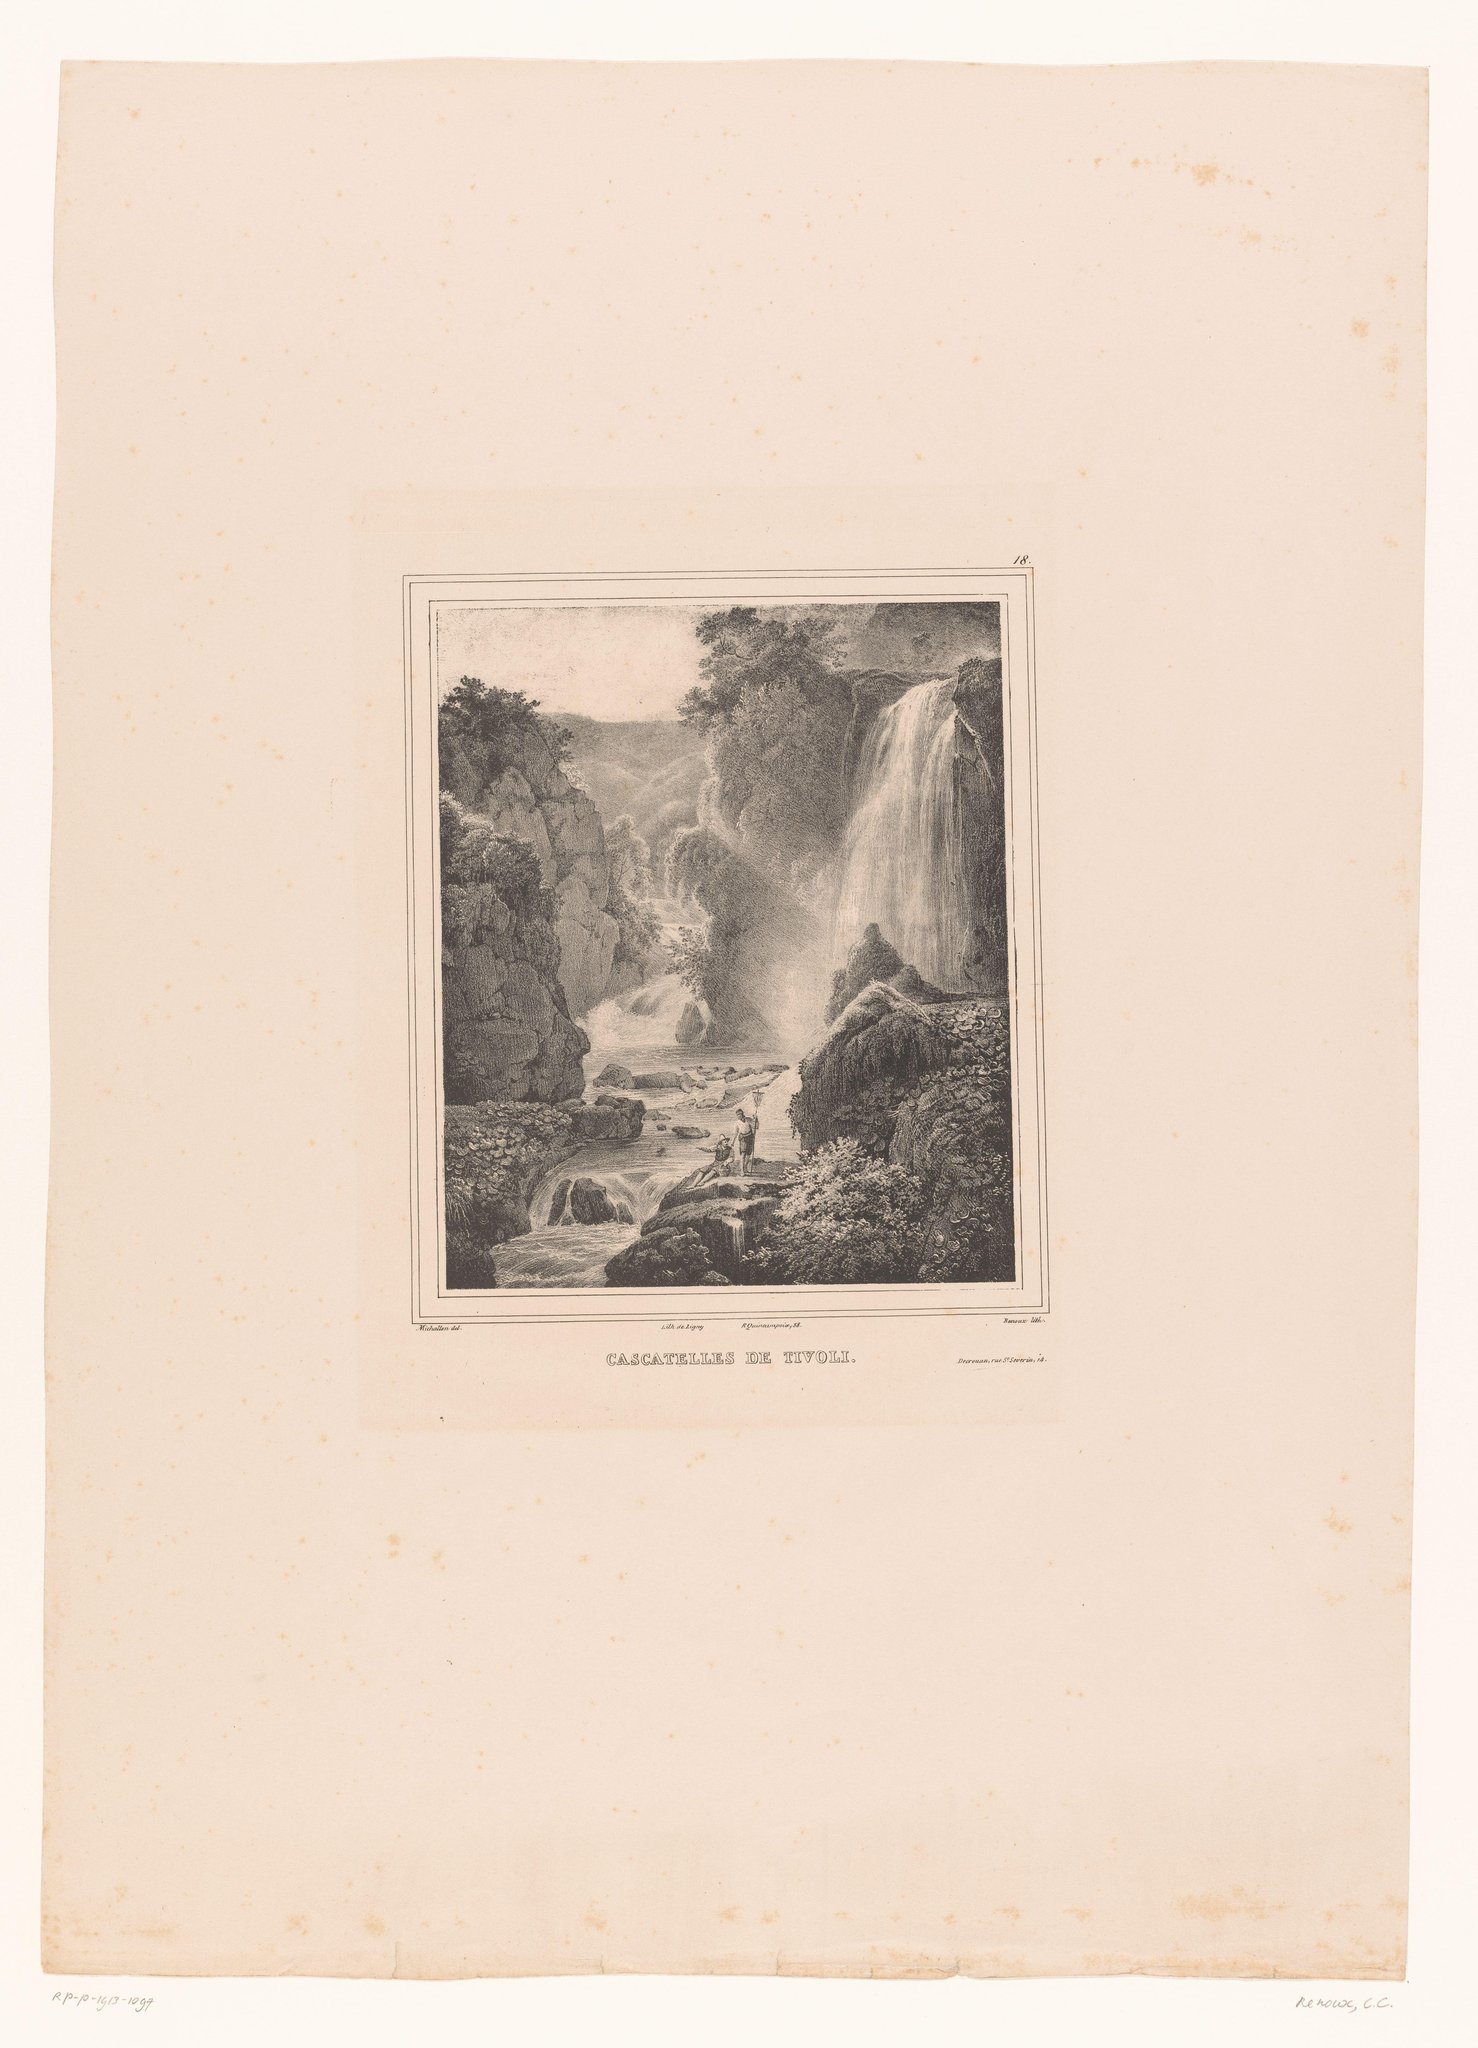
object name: print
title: Vues d'Italie et de Sicile, dessinées d'après nature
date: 1827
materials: paper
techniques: lithograph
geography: paris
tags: waterfall (+ landscape with figures, staffage), tivoli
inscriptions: collector's mark: Lugt 2228a